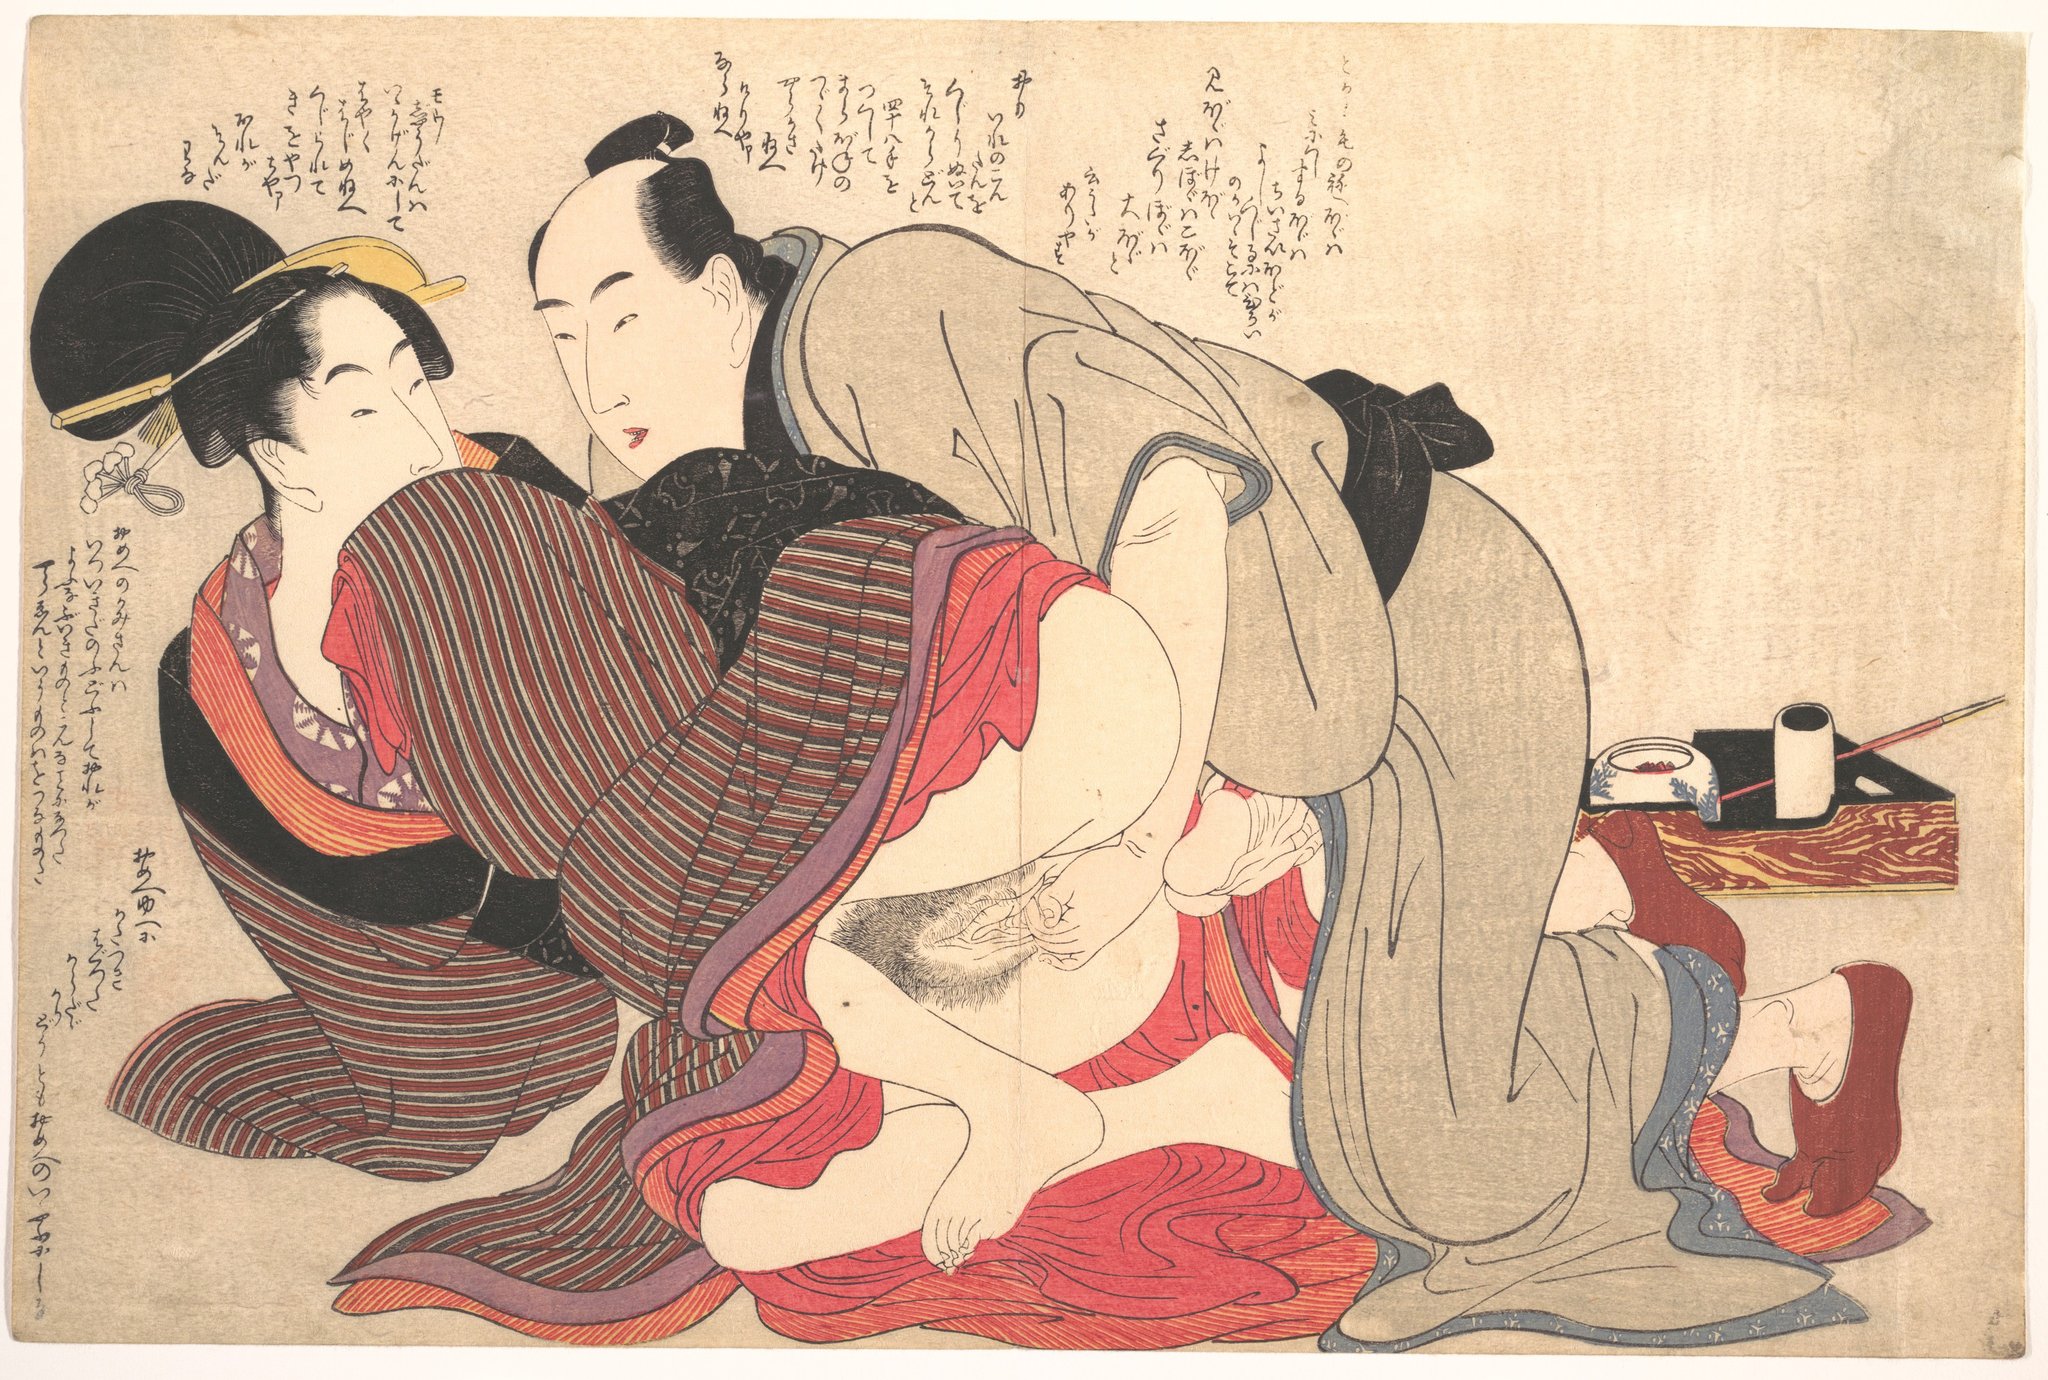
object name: print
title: Erotic Print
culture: japanese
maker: kitagawa utamaro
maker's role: artist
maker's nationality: japanese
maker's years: 1754-1806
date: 1753-1806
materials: ink, paper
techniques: woodblock print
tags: male nudes,female nudes